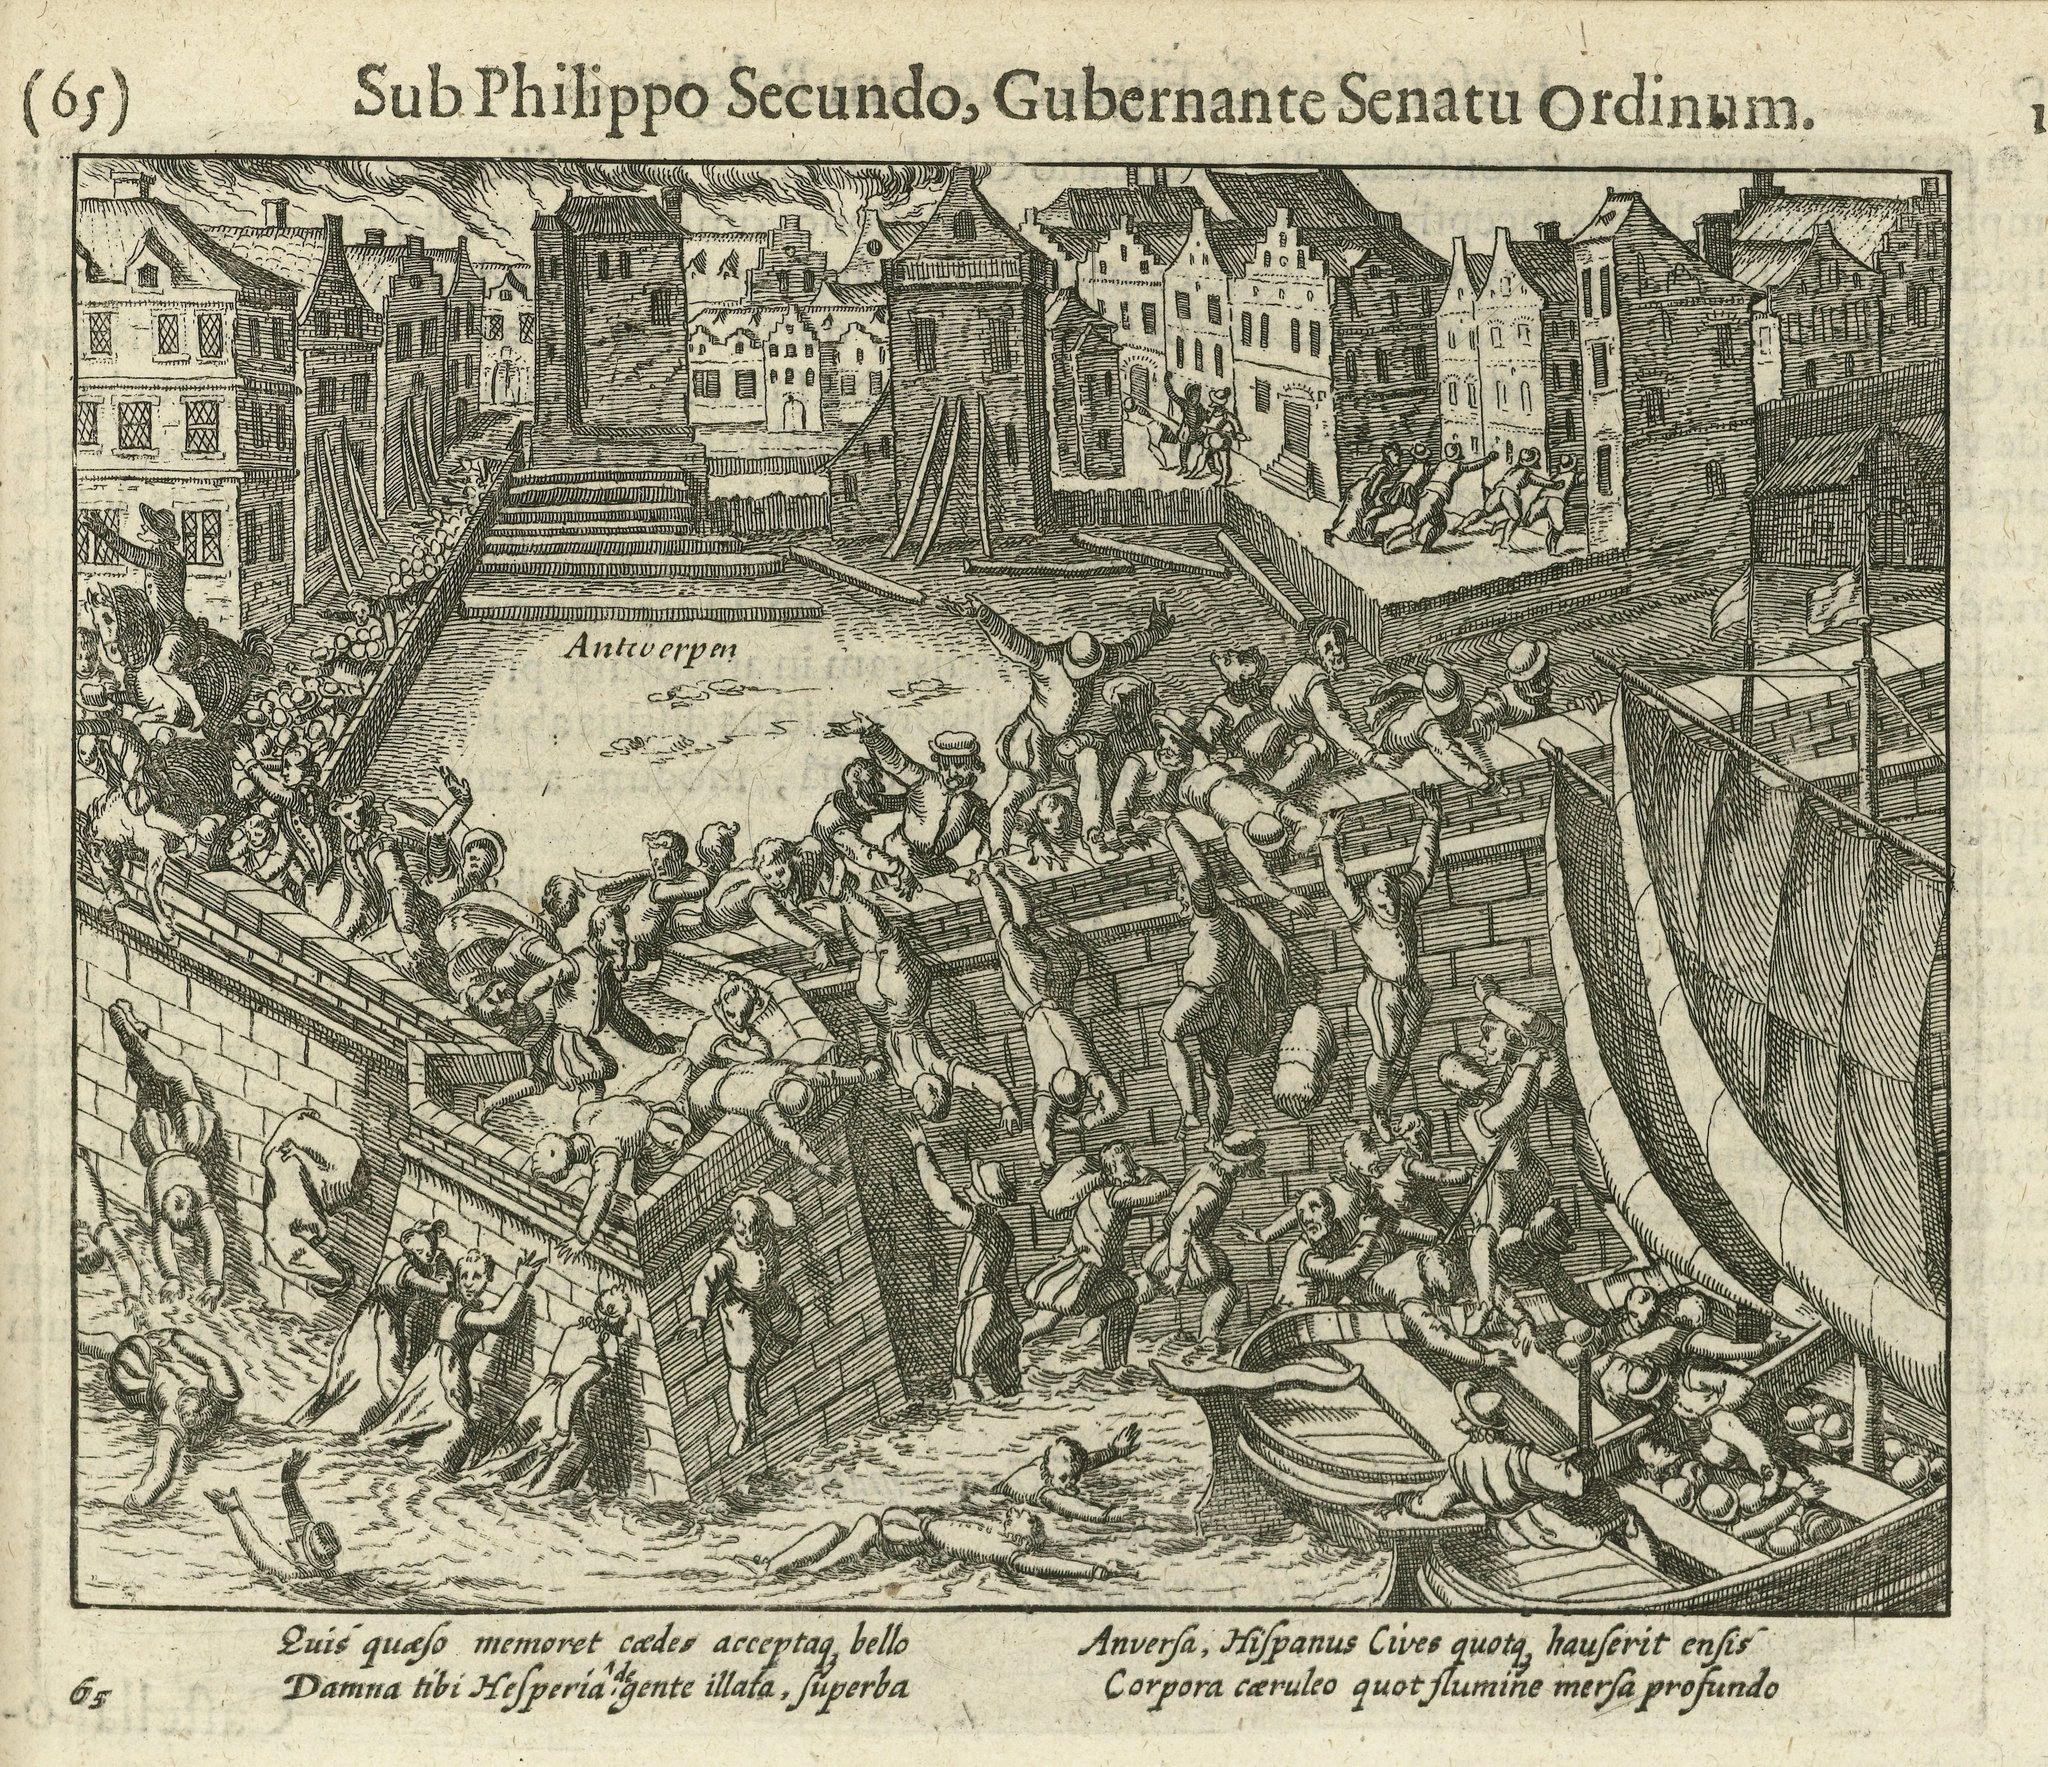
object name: history print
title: Spaanse Furie: inwoners vluchten in de Schelde, 1576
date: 1613-1615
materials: paper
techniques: etching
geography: northern netherlands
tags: massacre ~ war, antwerp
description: Spaanse Furie te Antwerpen, 4-7 november 1576. In een poging aan het geweld te ontsnappen springen Antwerpenaren in de Schelde en proberen te vluchten in bootjes. Met onderschrift van 4 regels in het Latijn. Genummerd: 65. Bedrukt op achterzijde met tekst in het Latijn.